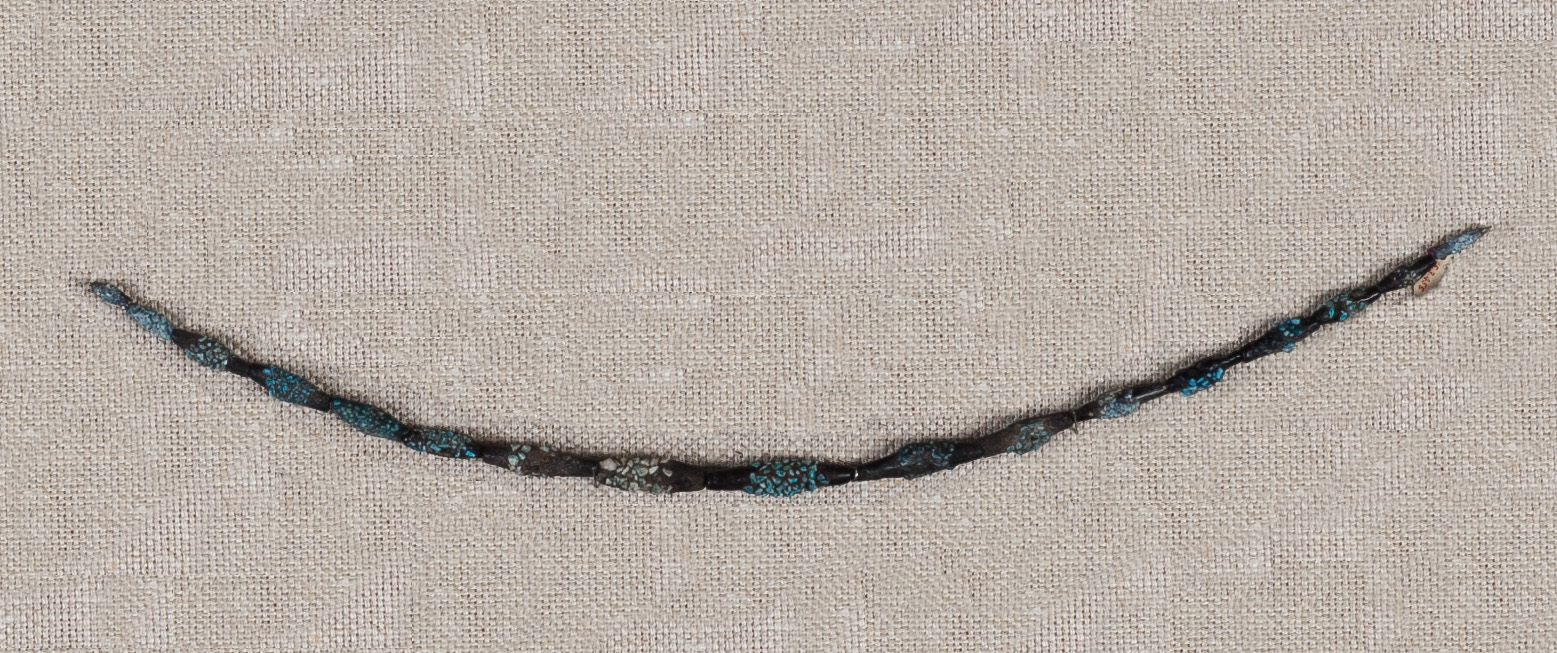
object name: necklace, bead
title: Necklace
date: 1981-1295 BCE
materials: faience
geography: egypt